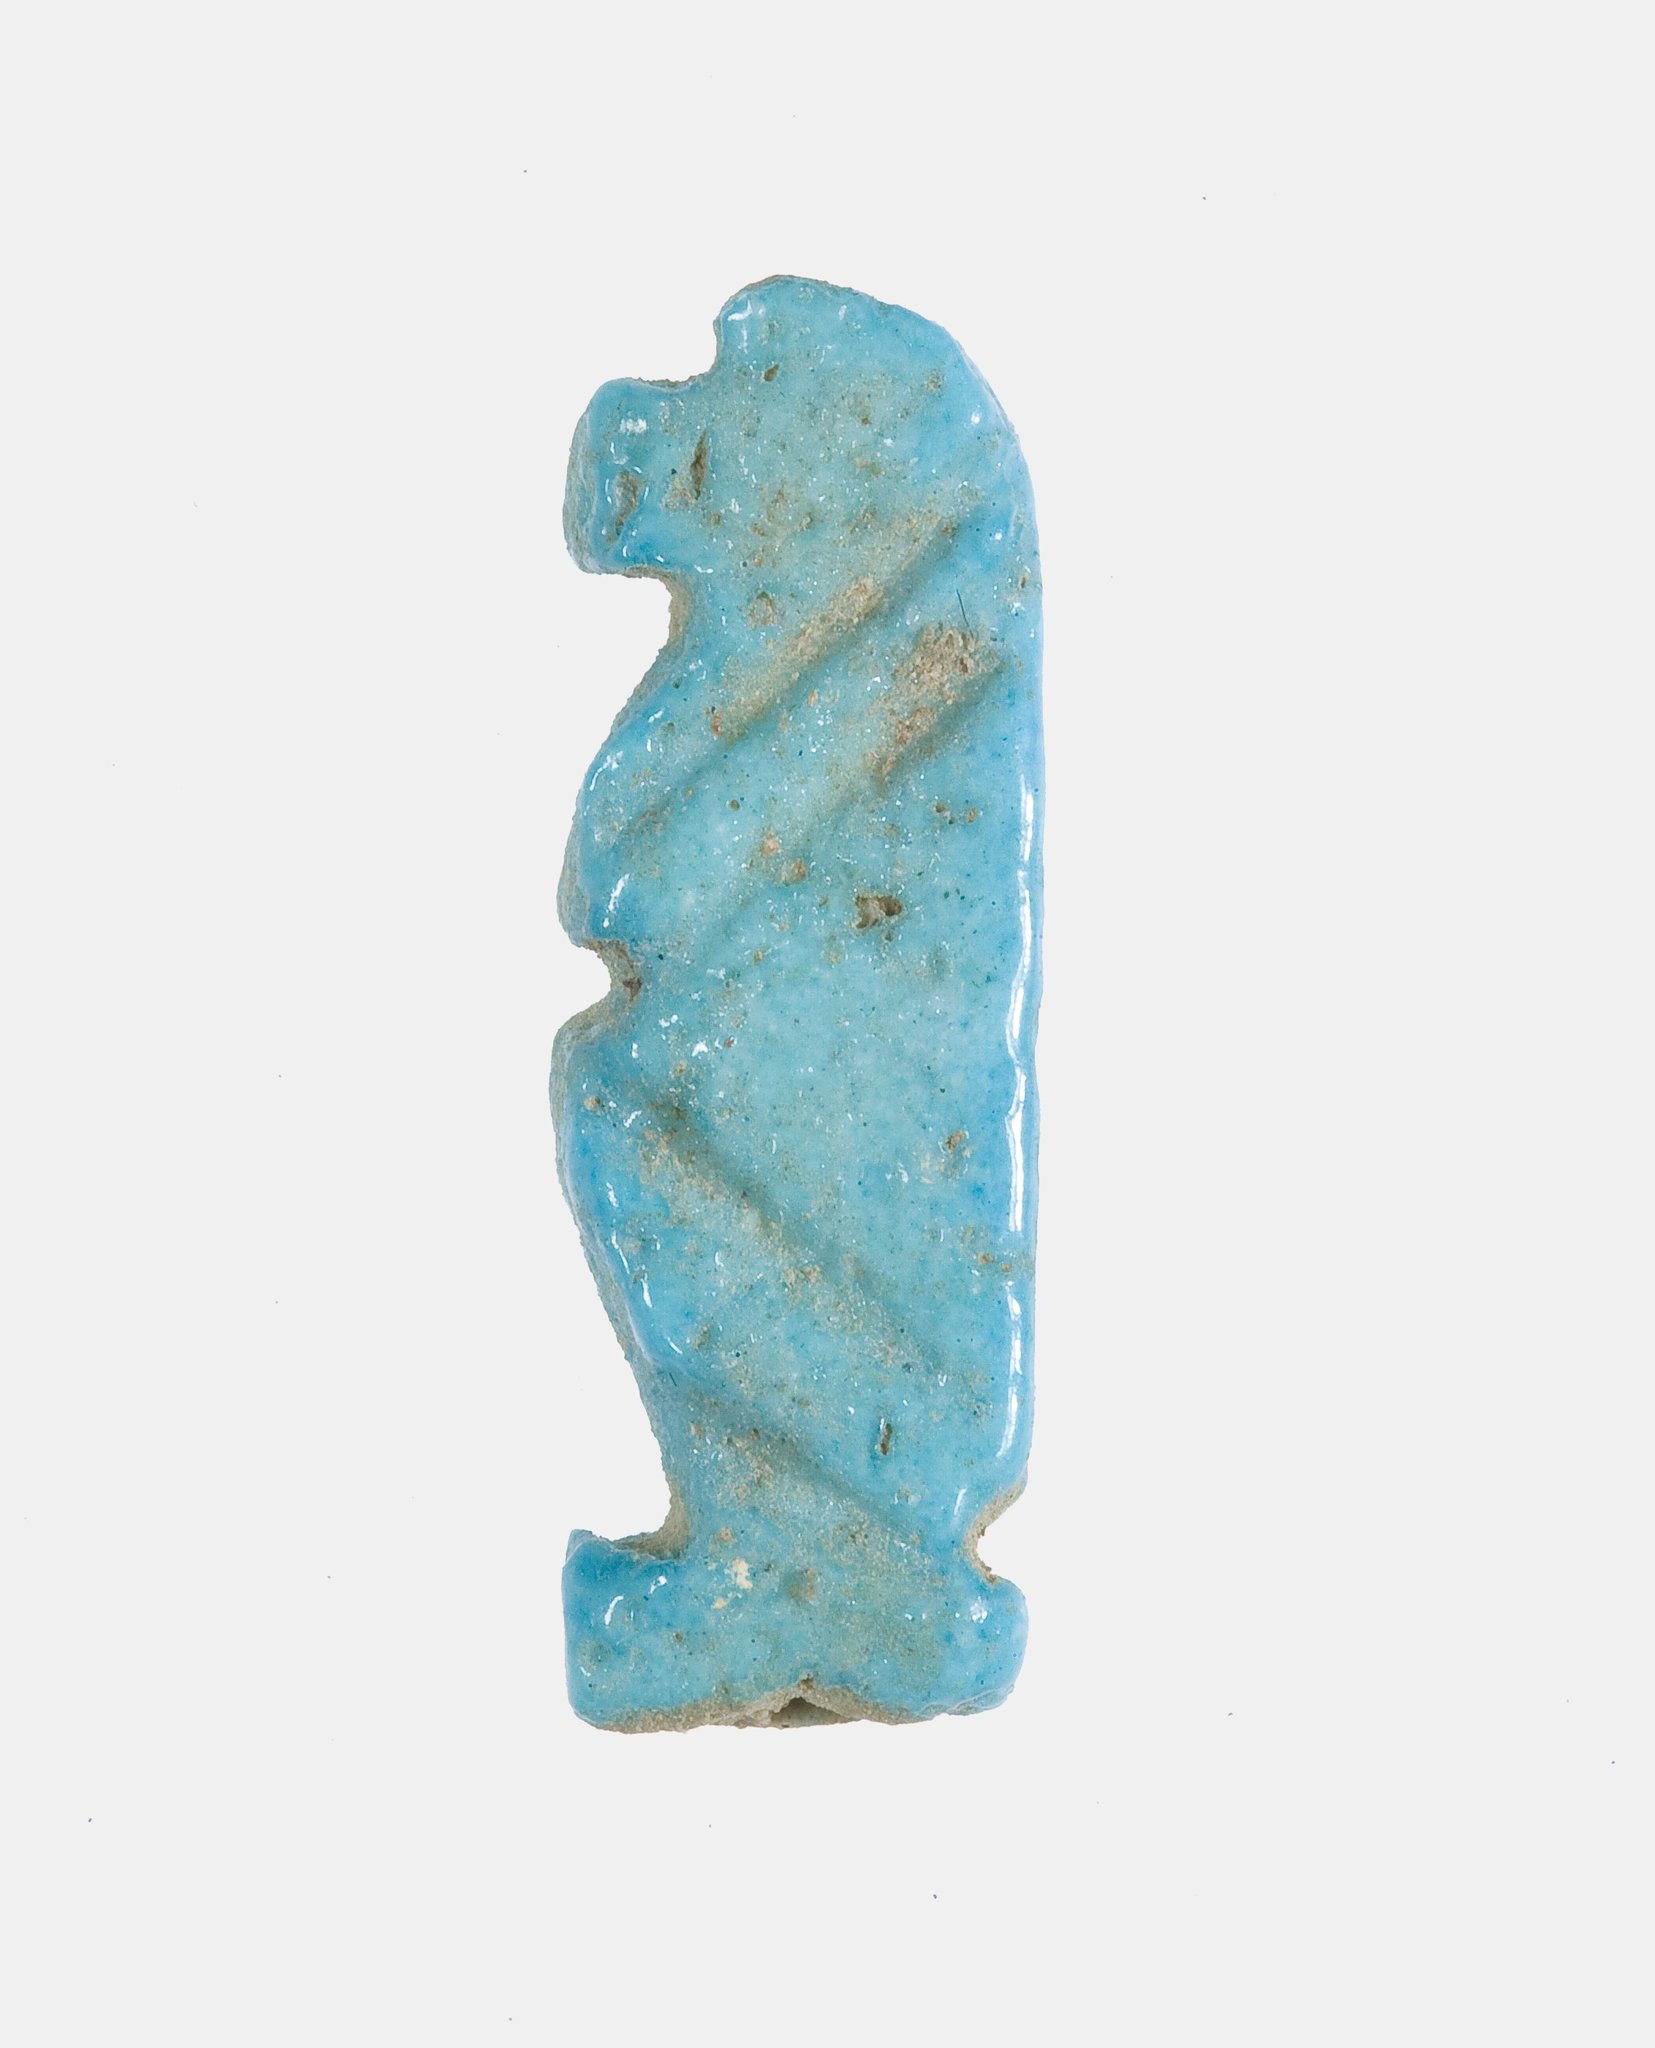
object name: amulet, monkey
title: Monkey Amulet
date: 1802-1450 BCE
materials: faience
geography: egypt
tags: monkeys